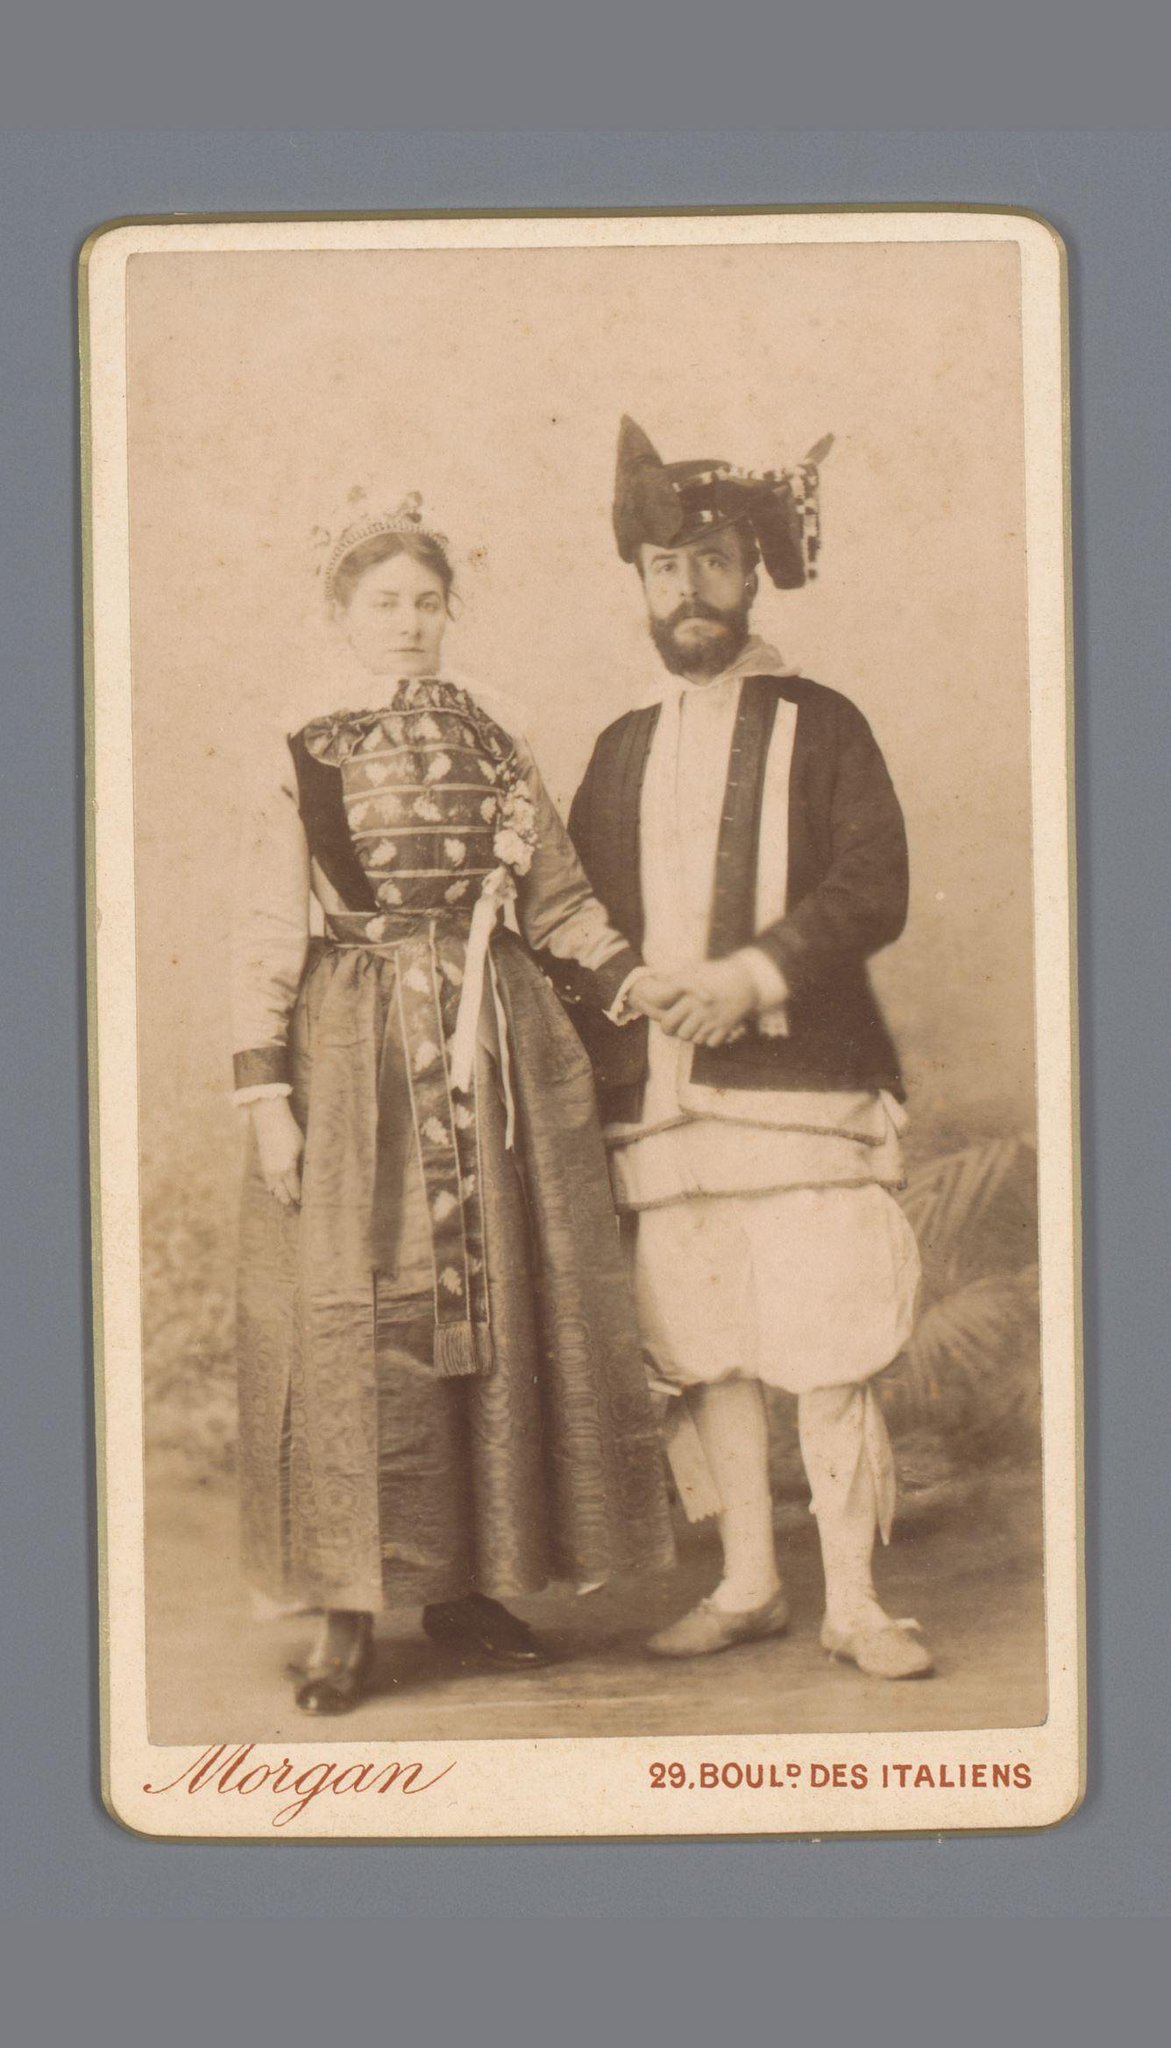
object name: photograph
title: Portret van een onbekende man en vrouw in klederdracht uit Bourg de Batz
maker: p. morgan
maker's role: printer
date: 1900-1914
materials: cardboard, paper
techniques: albumen print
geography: paris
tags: adult woman, adult man, anonymous historical person portrayed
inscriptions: inscription: ‘L & D. PARIS’, inscription: ‘MÉDAILLE D'ARGENT/ Paris, Exposition Universelle 1889/ PHOTOGRAPHIE . REPRODUCTION/ AGRANDISSEMENTS’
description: Waarschijnlijk gaat het hier om kostuums geïnspireerd op daadwerkelijke klederdracht uit Bourg de Batz. Toeristen lieten zich aan het eind van de 19e eeuw in dergelijke kostuums fotograferen bij een bezoek aan de badplaats.